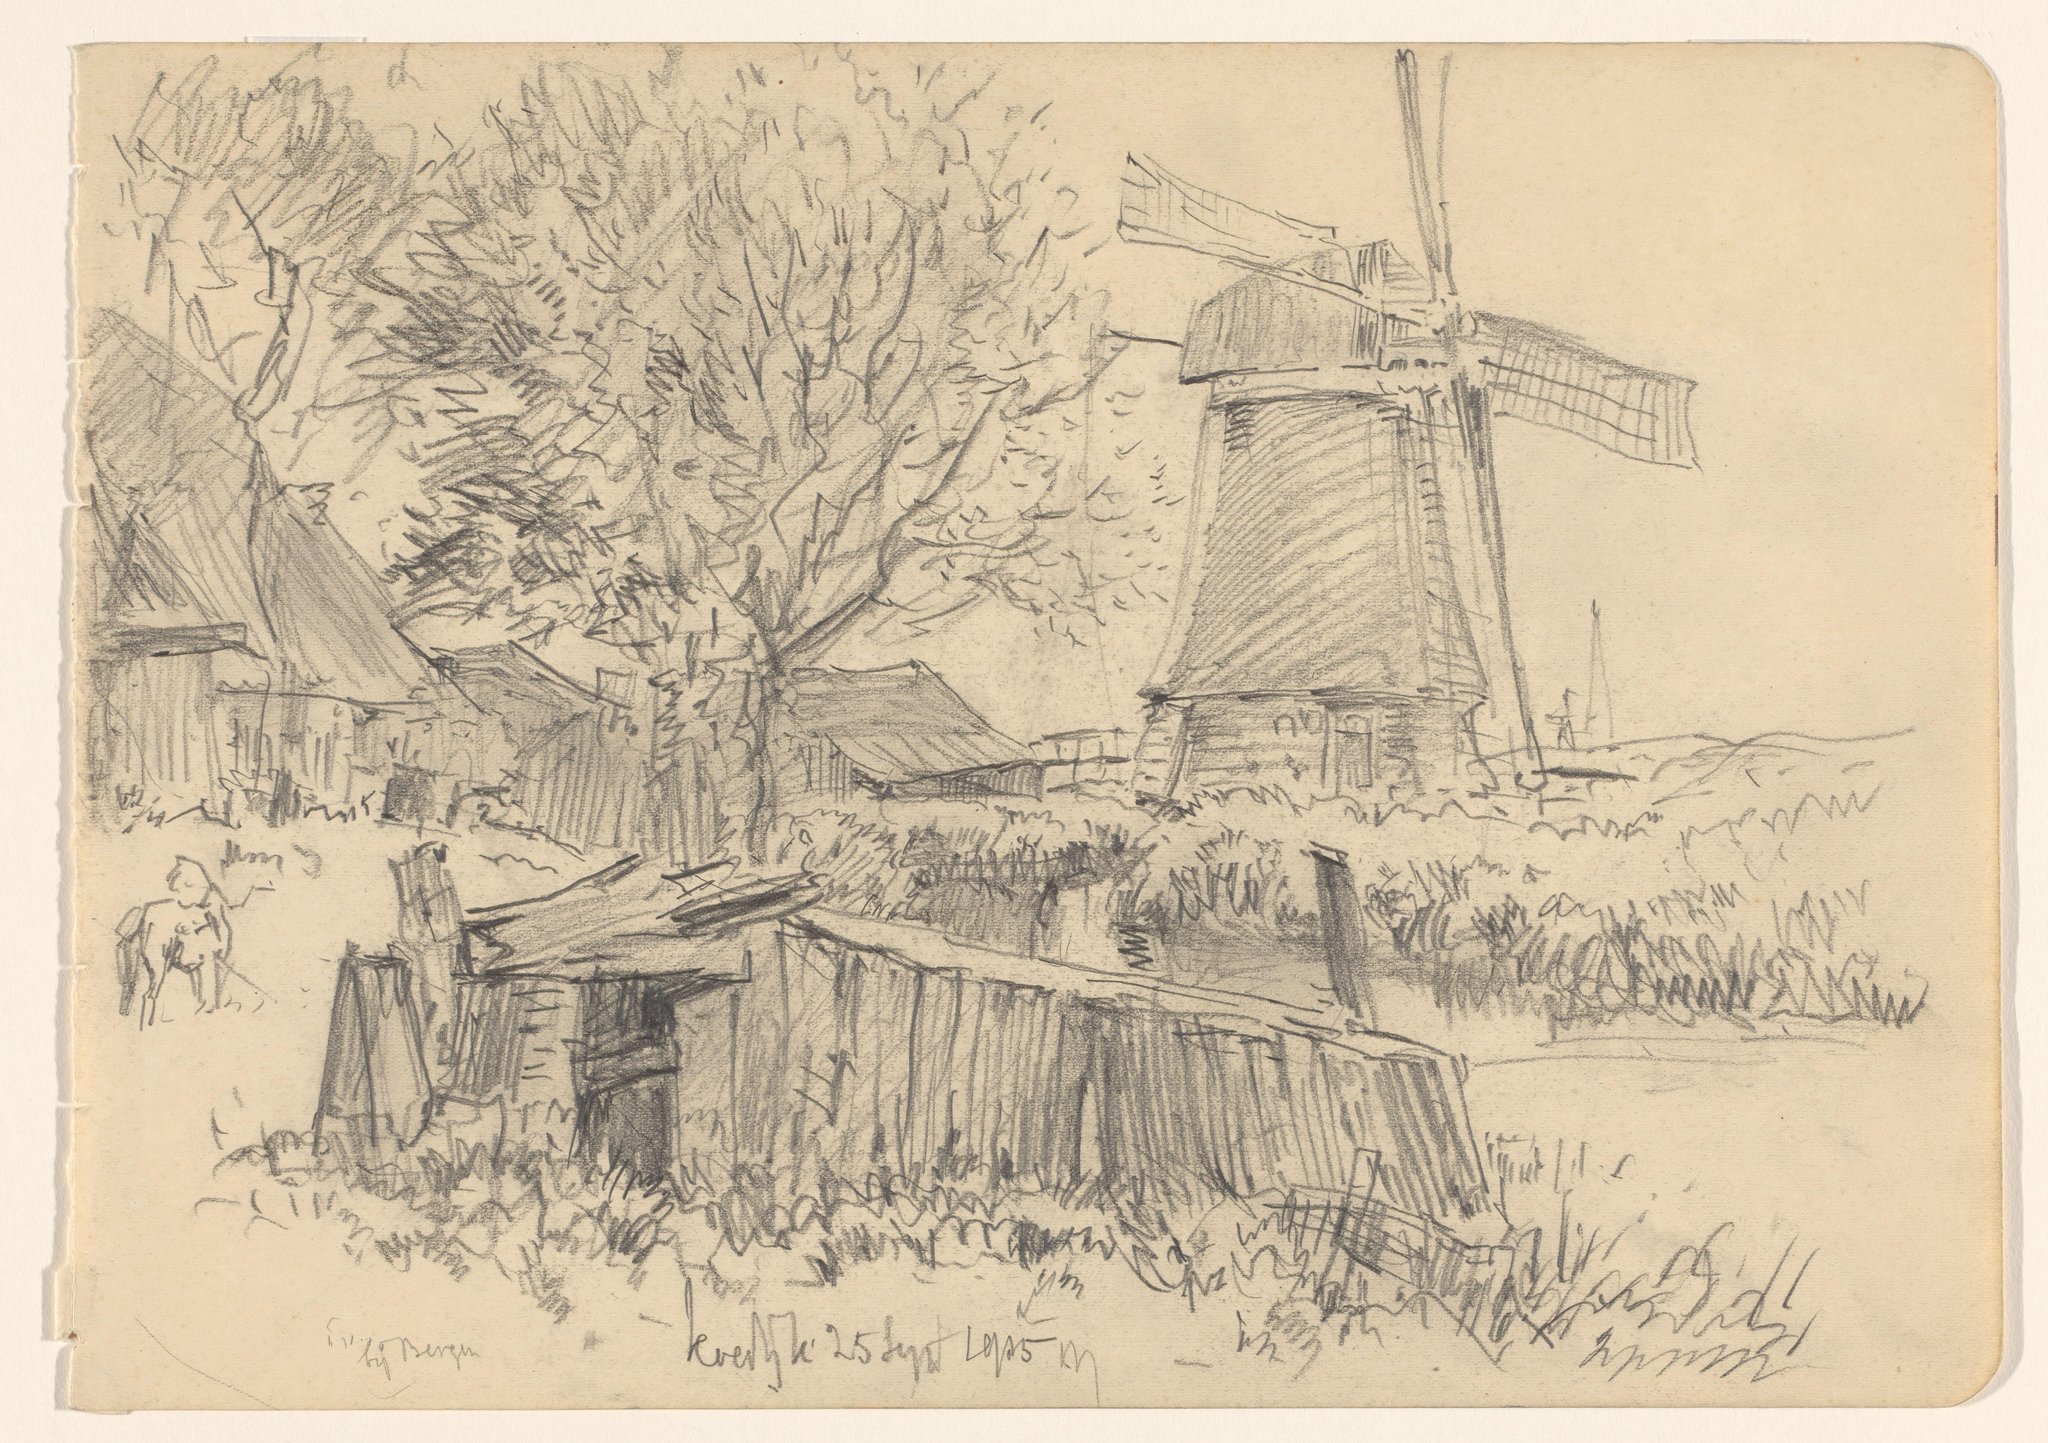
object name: drawing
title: Landschap met molen te Koedijk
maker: jan hoynck van papendrecht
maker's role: draughtsman, painter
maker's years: 1858-1933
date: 1915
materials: paper, pencil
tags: windmill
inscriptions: annotation: ‘bij Bergen/ Koedijk 25 Sept 1915’, collector's mark: Lugt 2228